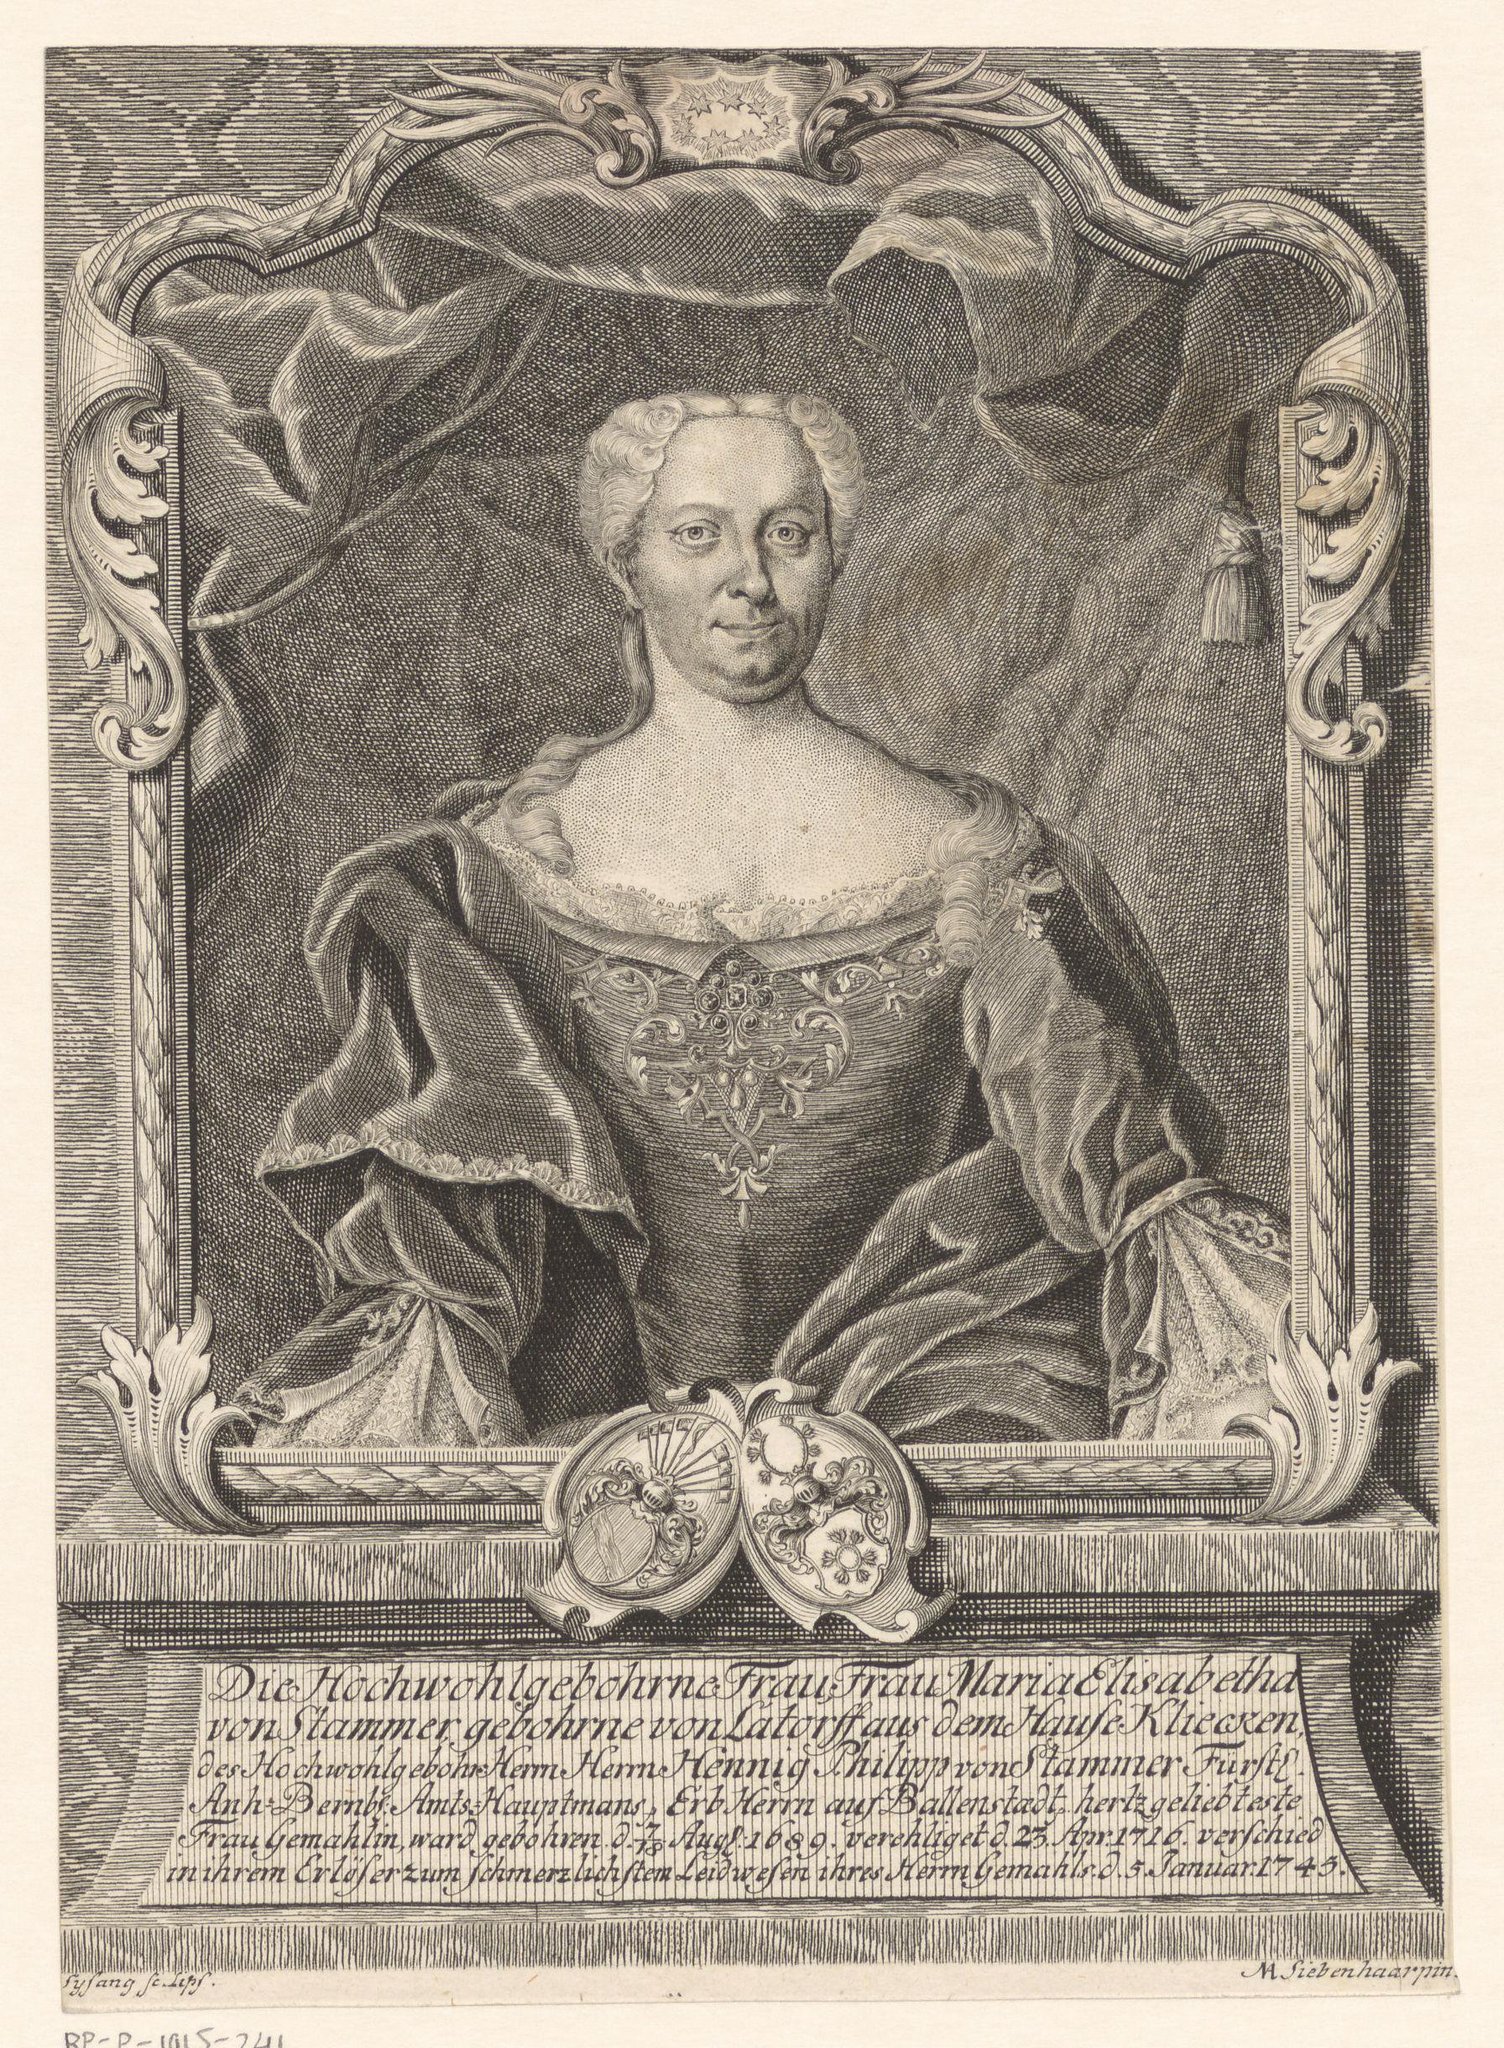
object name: print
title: Portret van Maria Elisabeth von Lattorff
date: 1745-1757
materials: paper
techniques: engraving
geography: leipzig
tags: historical persons - bb - woman, armorial bearing, heraldry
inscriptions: collector's mark: Lugt 2228, collector's mark: Lugt 358, number: ‘2.6929’